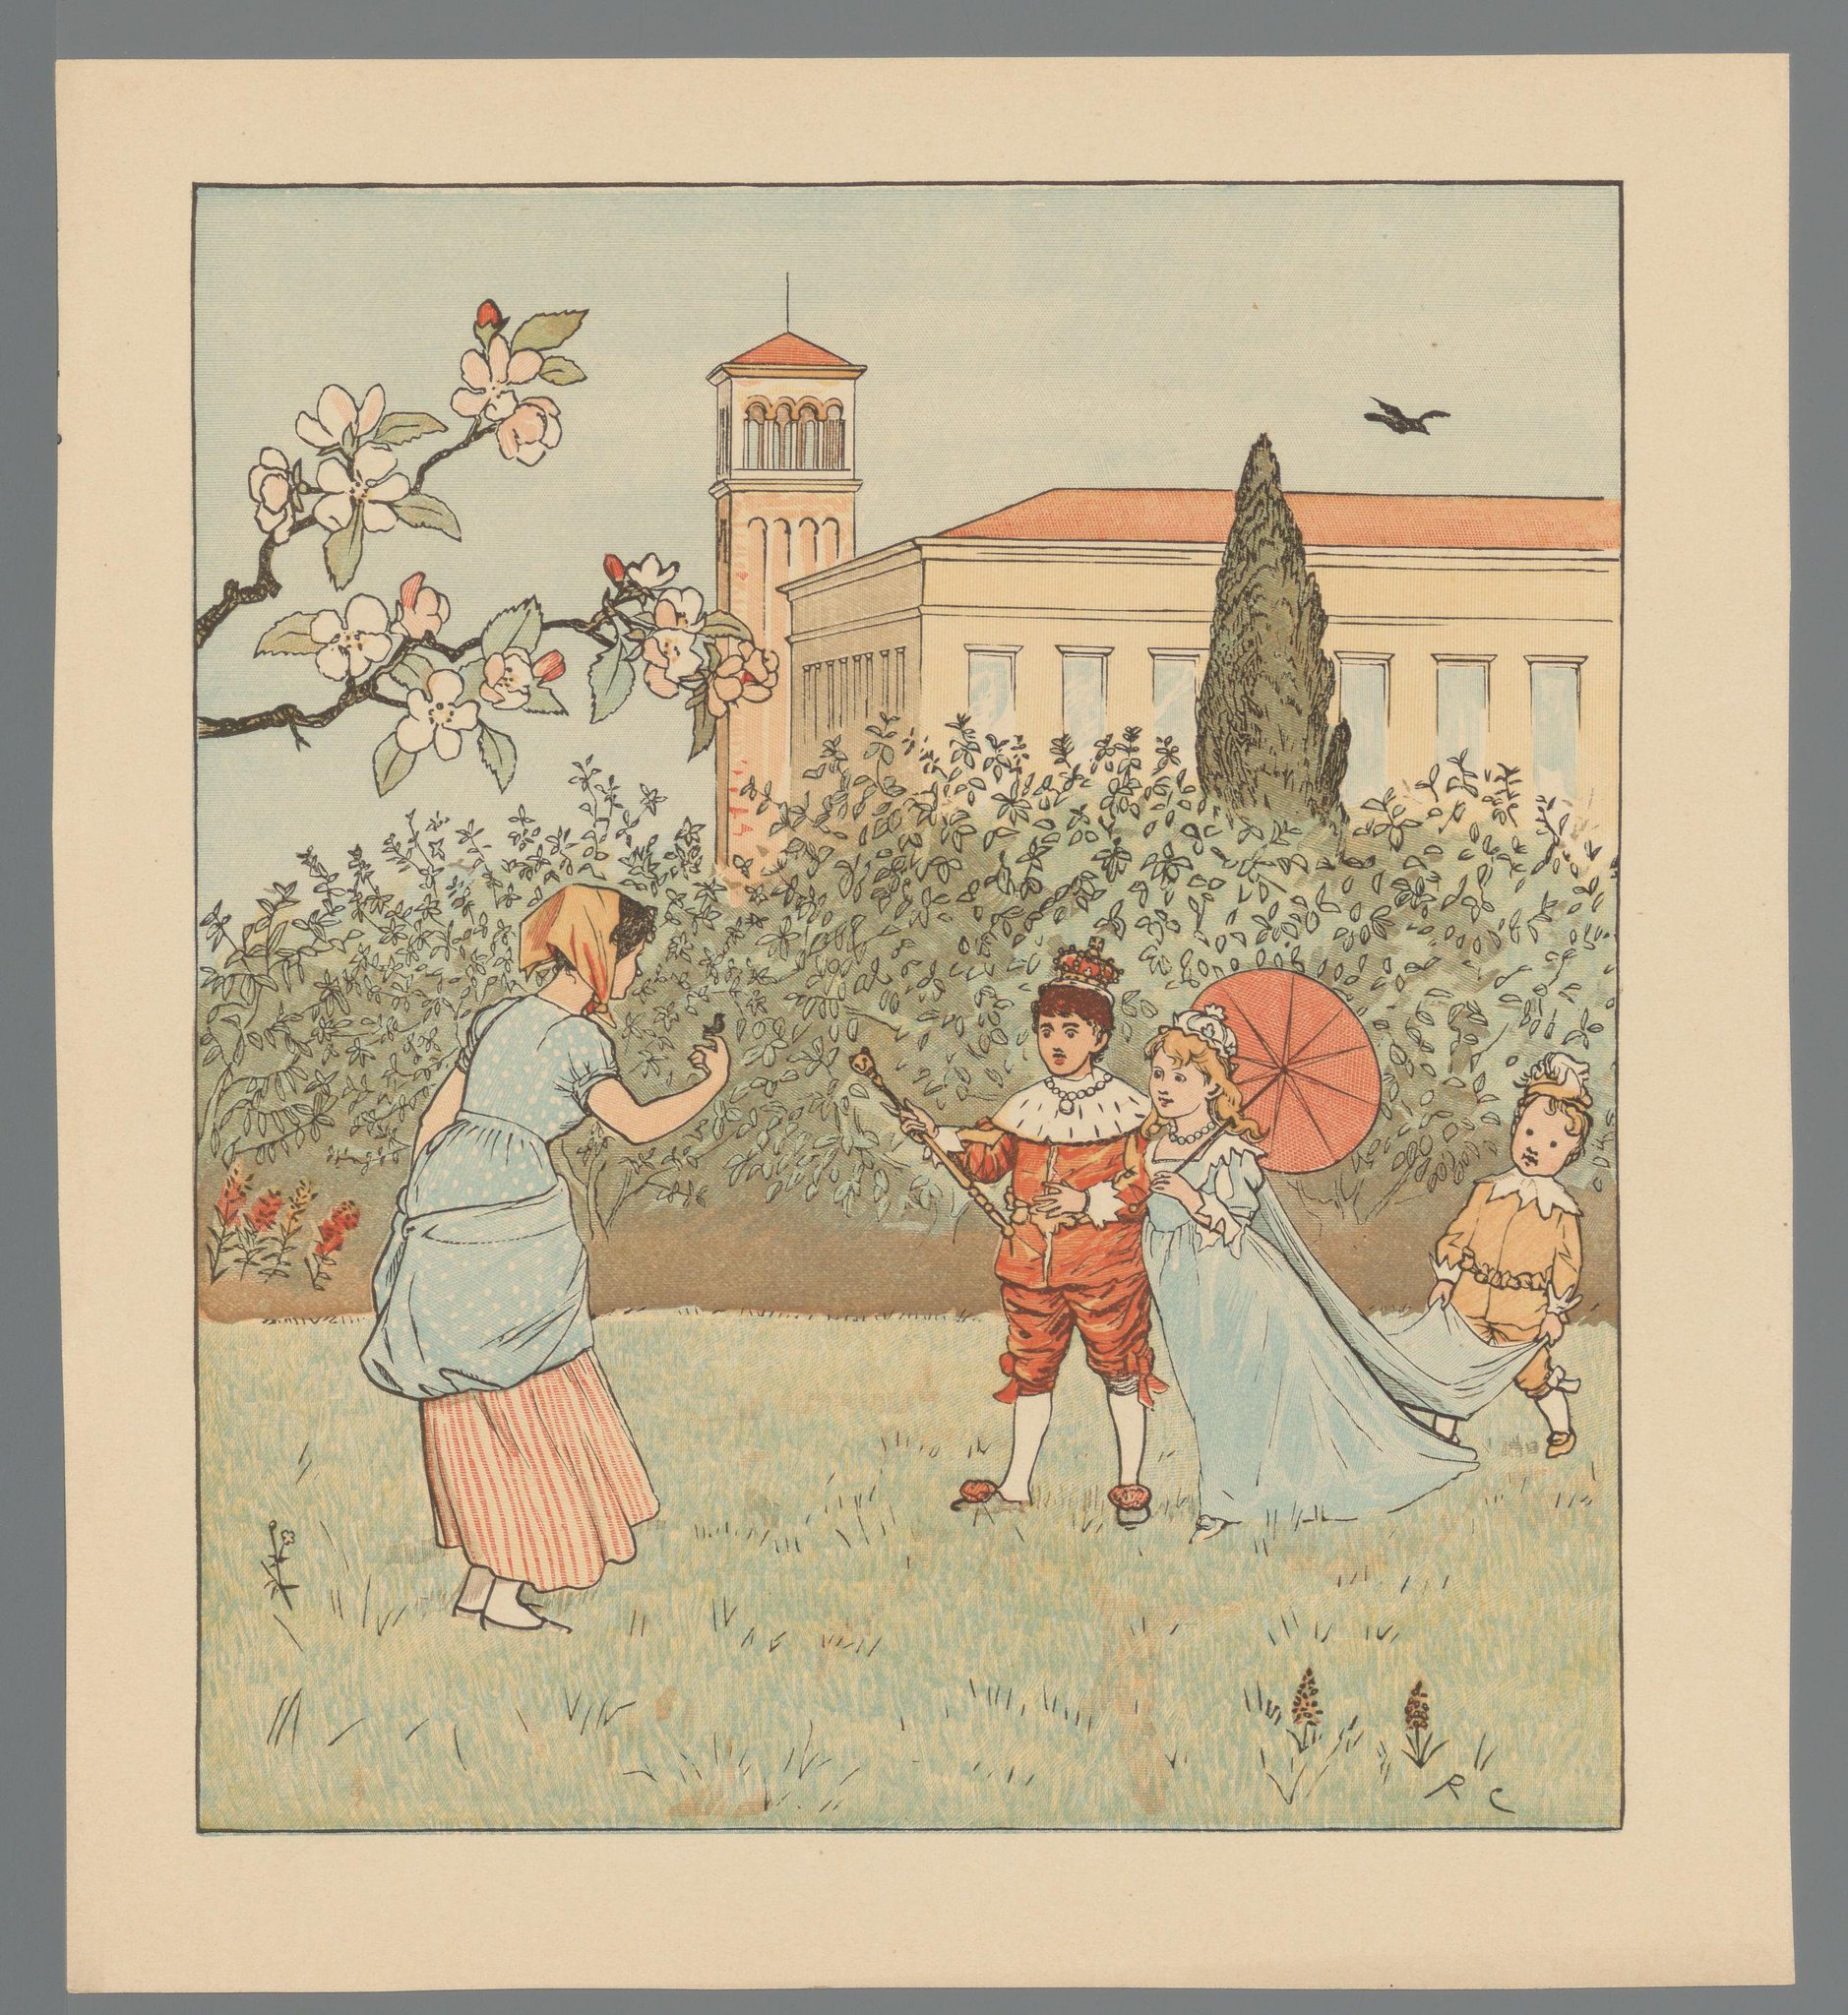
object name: book illustration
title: Tuin met koninklijk paar en vrouw met vogel op haar hand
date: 1880-1927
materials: paper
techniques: wood engraving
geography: london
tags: garden, ranks ~ rulers, sovereigns, house personnel, servants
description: Prent uit: Sing a song of sixpence. Londen: George Routledge & Sons, 1880. Of uit een later gepubliceerde (gebundelde) uitgave.